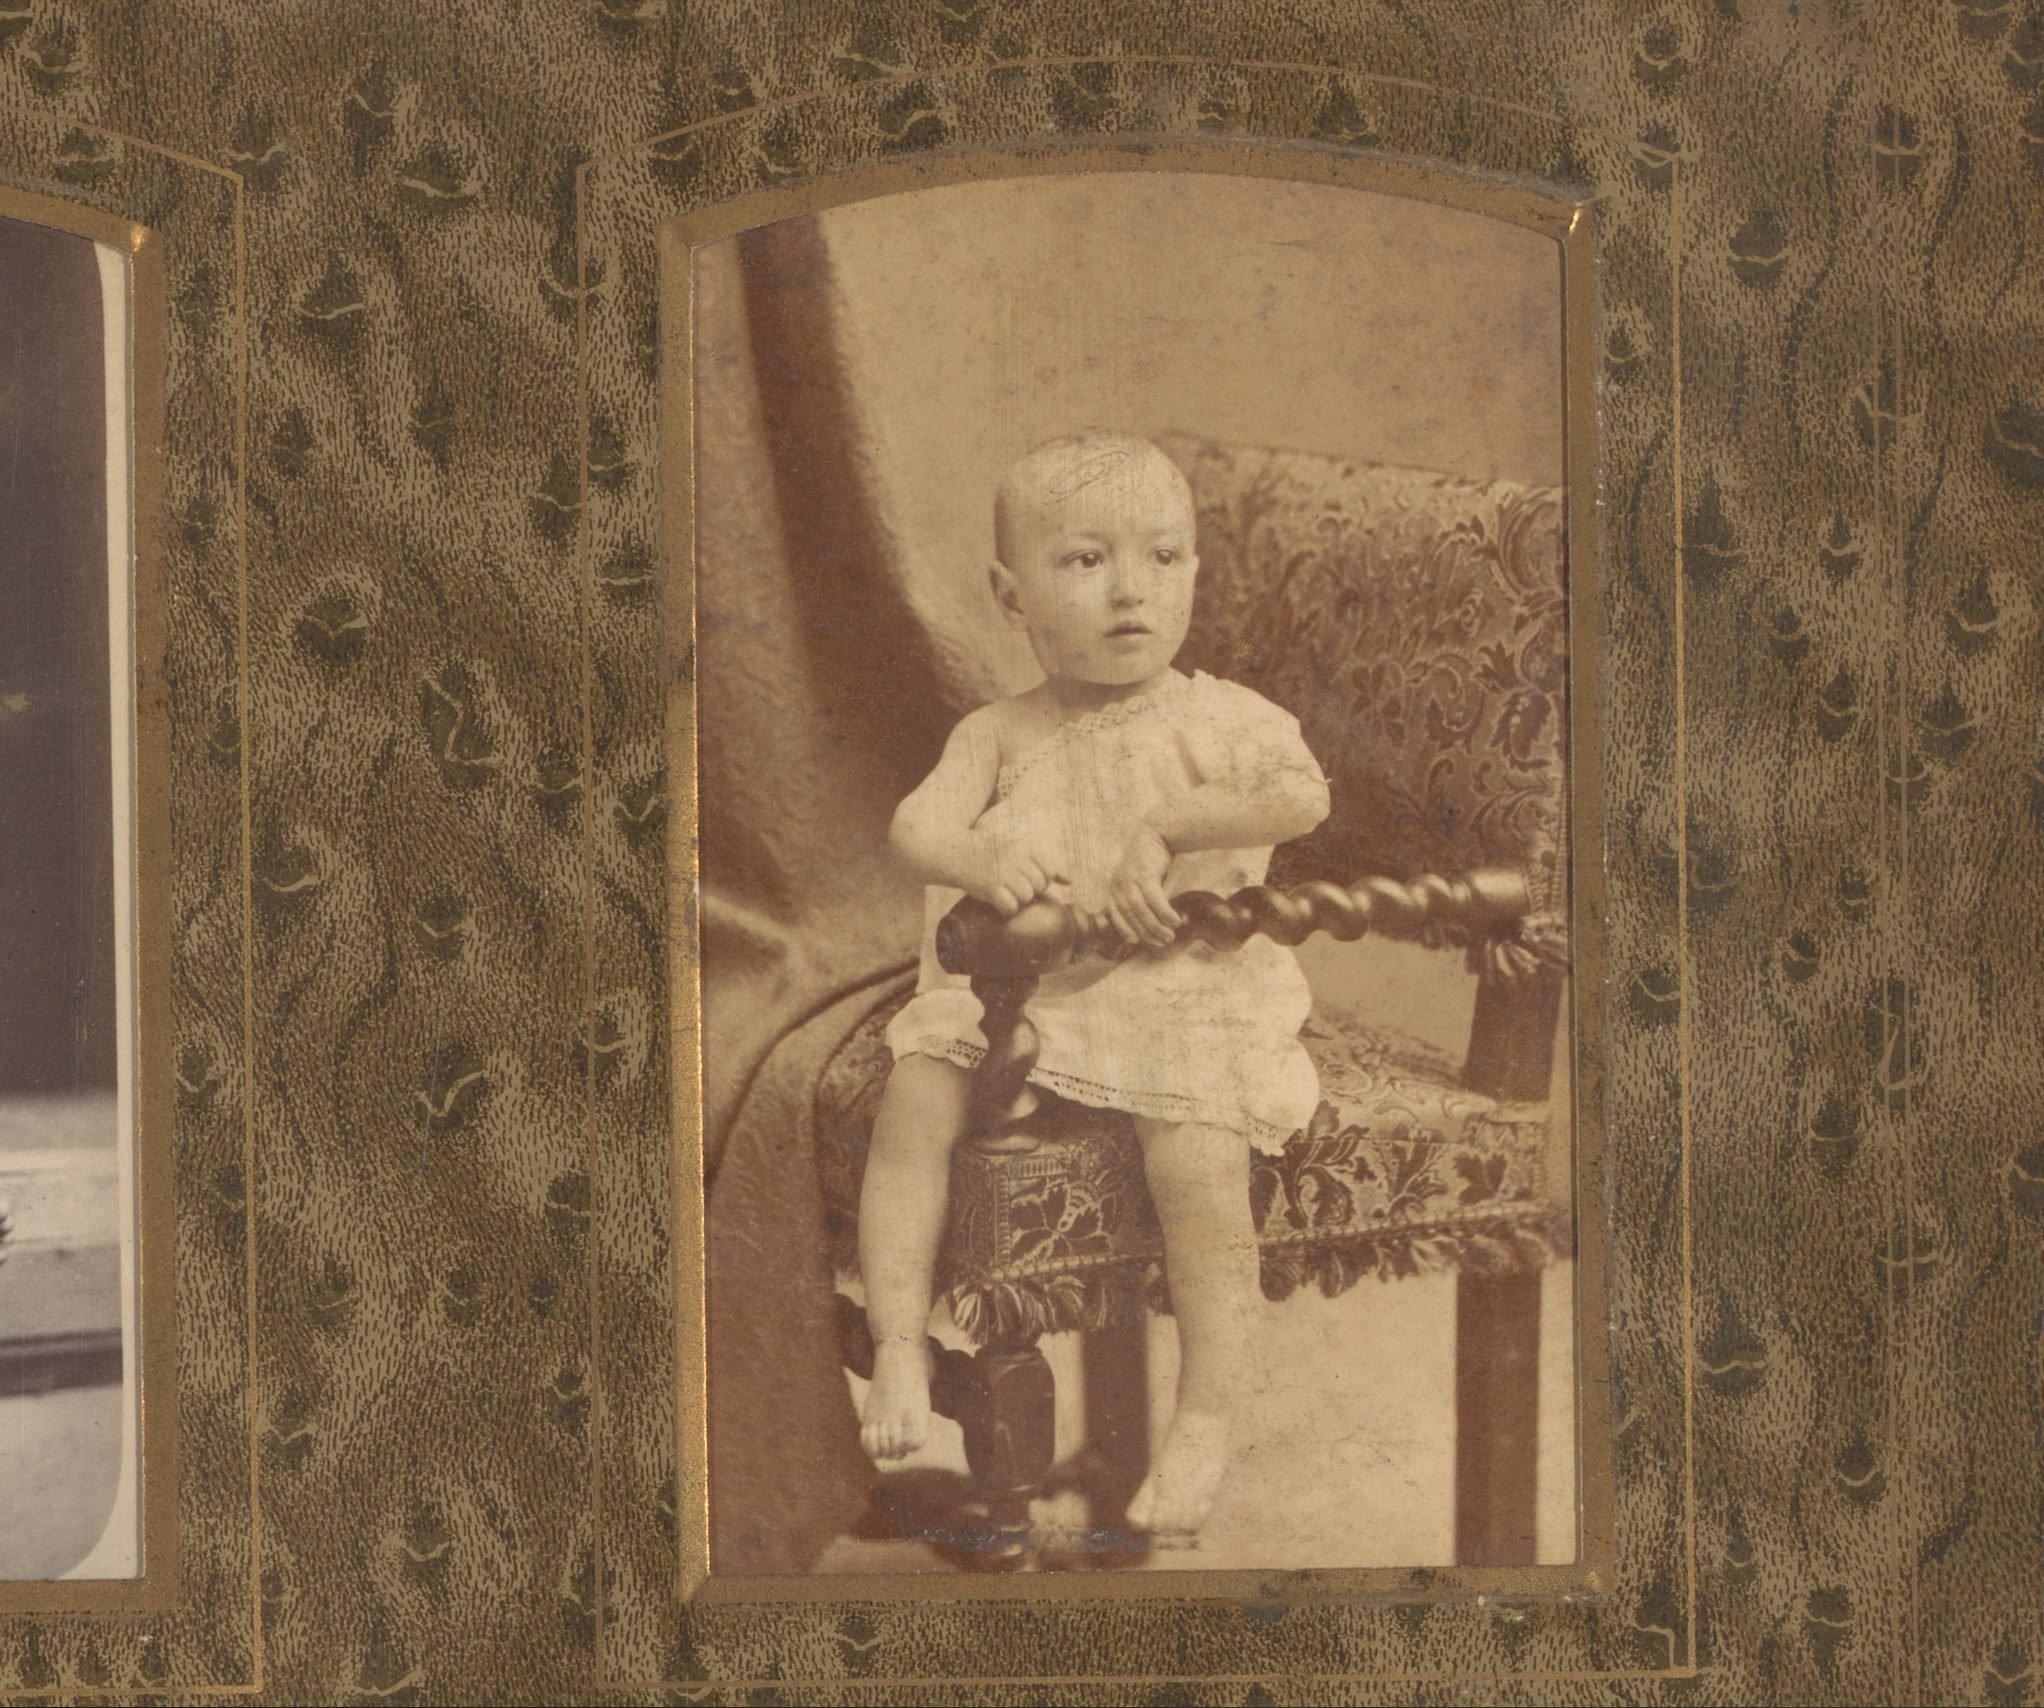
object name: carte de visite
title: Portret van een peuter op een stoel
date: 1882-1900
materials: cardboard, photographic support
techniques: albumen print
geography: grenoble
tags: toddler (male) (+ sitting), historical persons, chair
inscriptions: inscription: ‘Photographie/ Martinotto frères/ EXPOSITION DE BORDEAUX/ (...)/ 1882/ LES CLICHÉS ÉTANT CONSERVÉS/ ON PEUT DEMANDER DES CARTES/ SANS POSER DE NOUVEAU/ Grenoble/ Avenue de la Gare No. 6./ et Uriage-les-Bains/ D. HUTINET-PARIS’